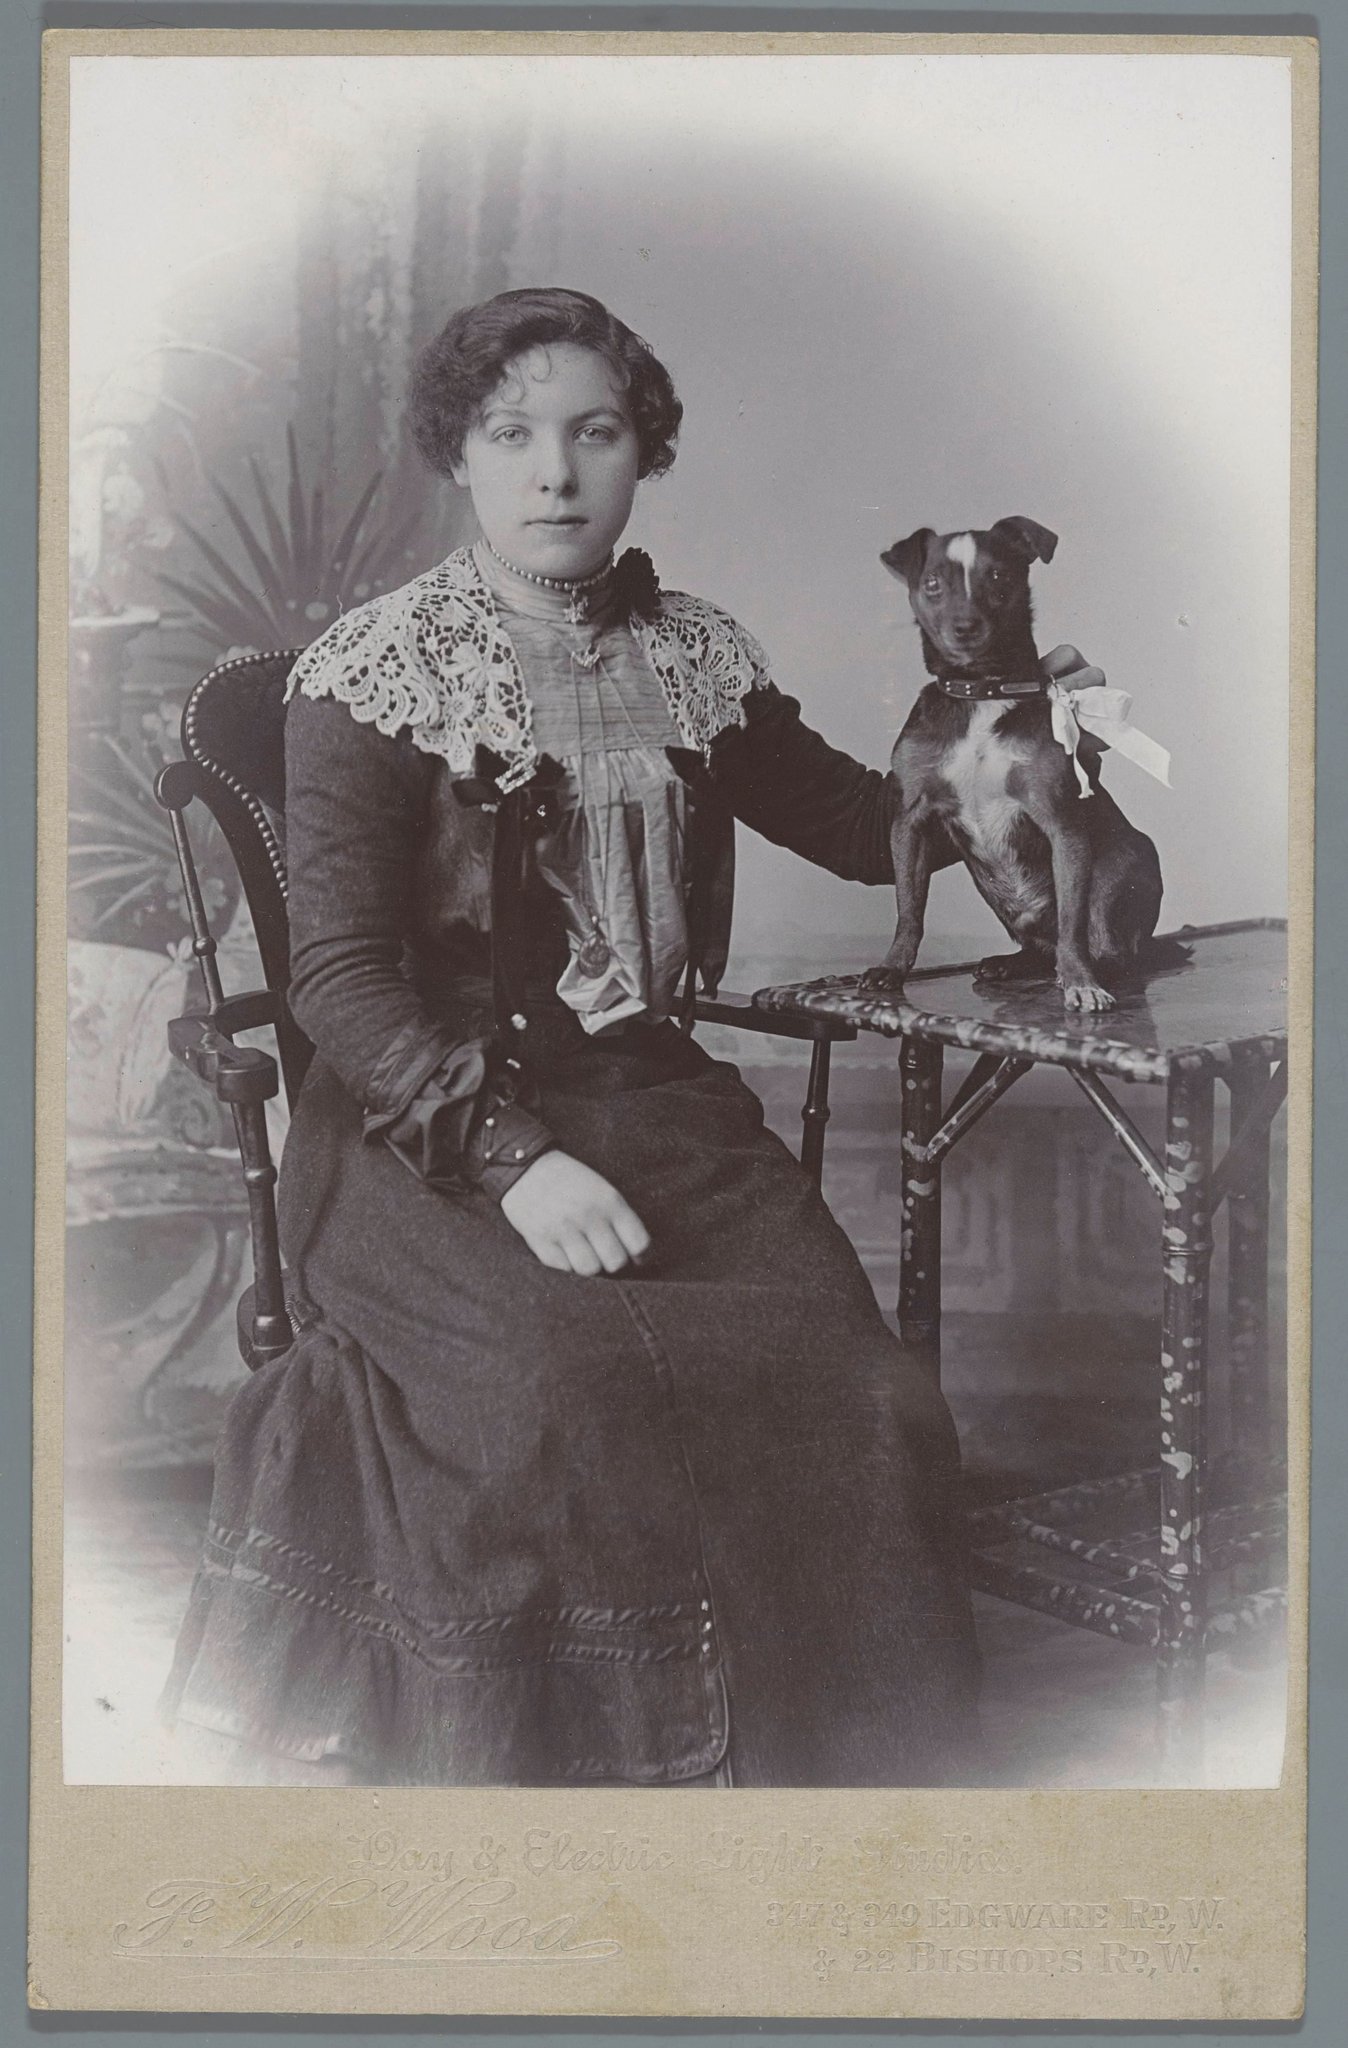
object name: cabinet photograph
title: Portret van een onbekende vrouw met een hond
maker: frederick william wood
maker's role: fotograaf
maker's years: 1870-1947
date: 1880-1905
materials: cardboard, photographic support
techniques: gelatin silver print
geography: london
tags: adult woman, dog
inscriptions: inscription: ‘Day & Electric Light Studios (...) customers own prices.’